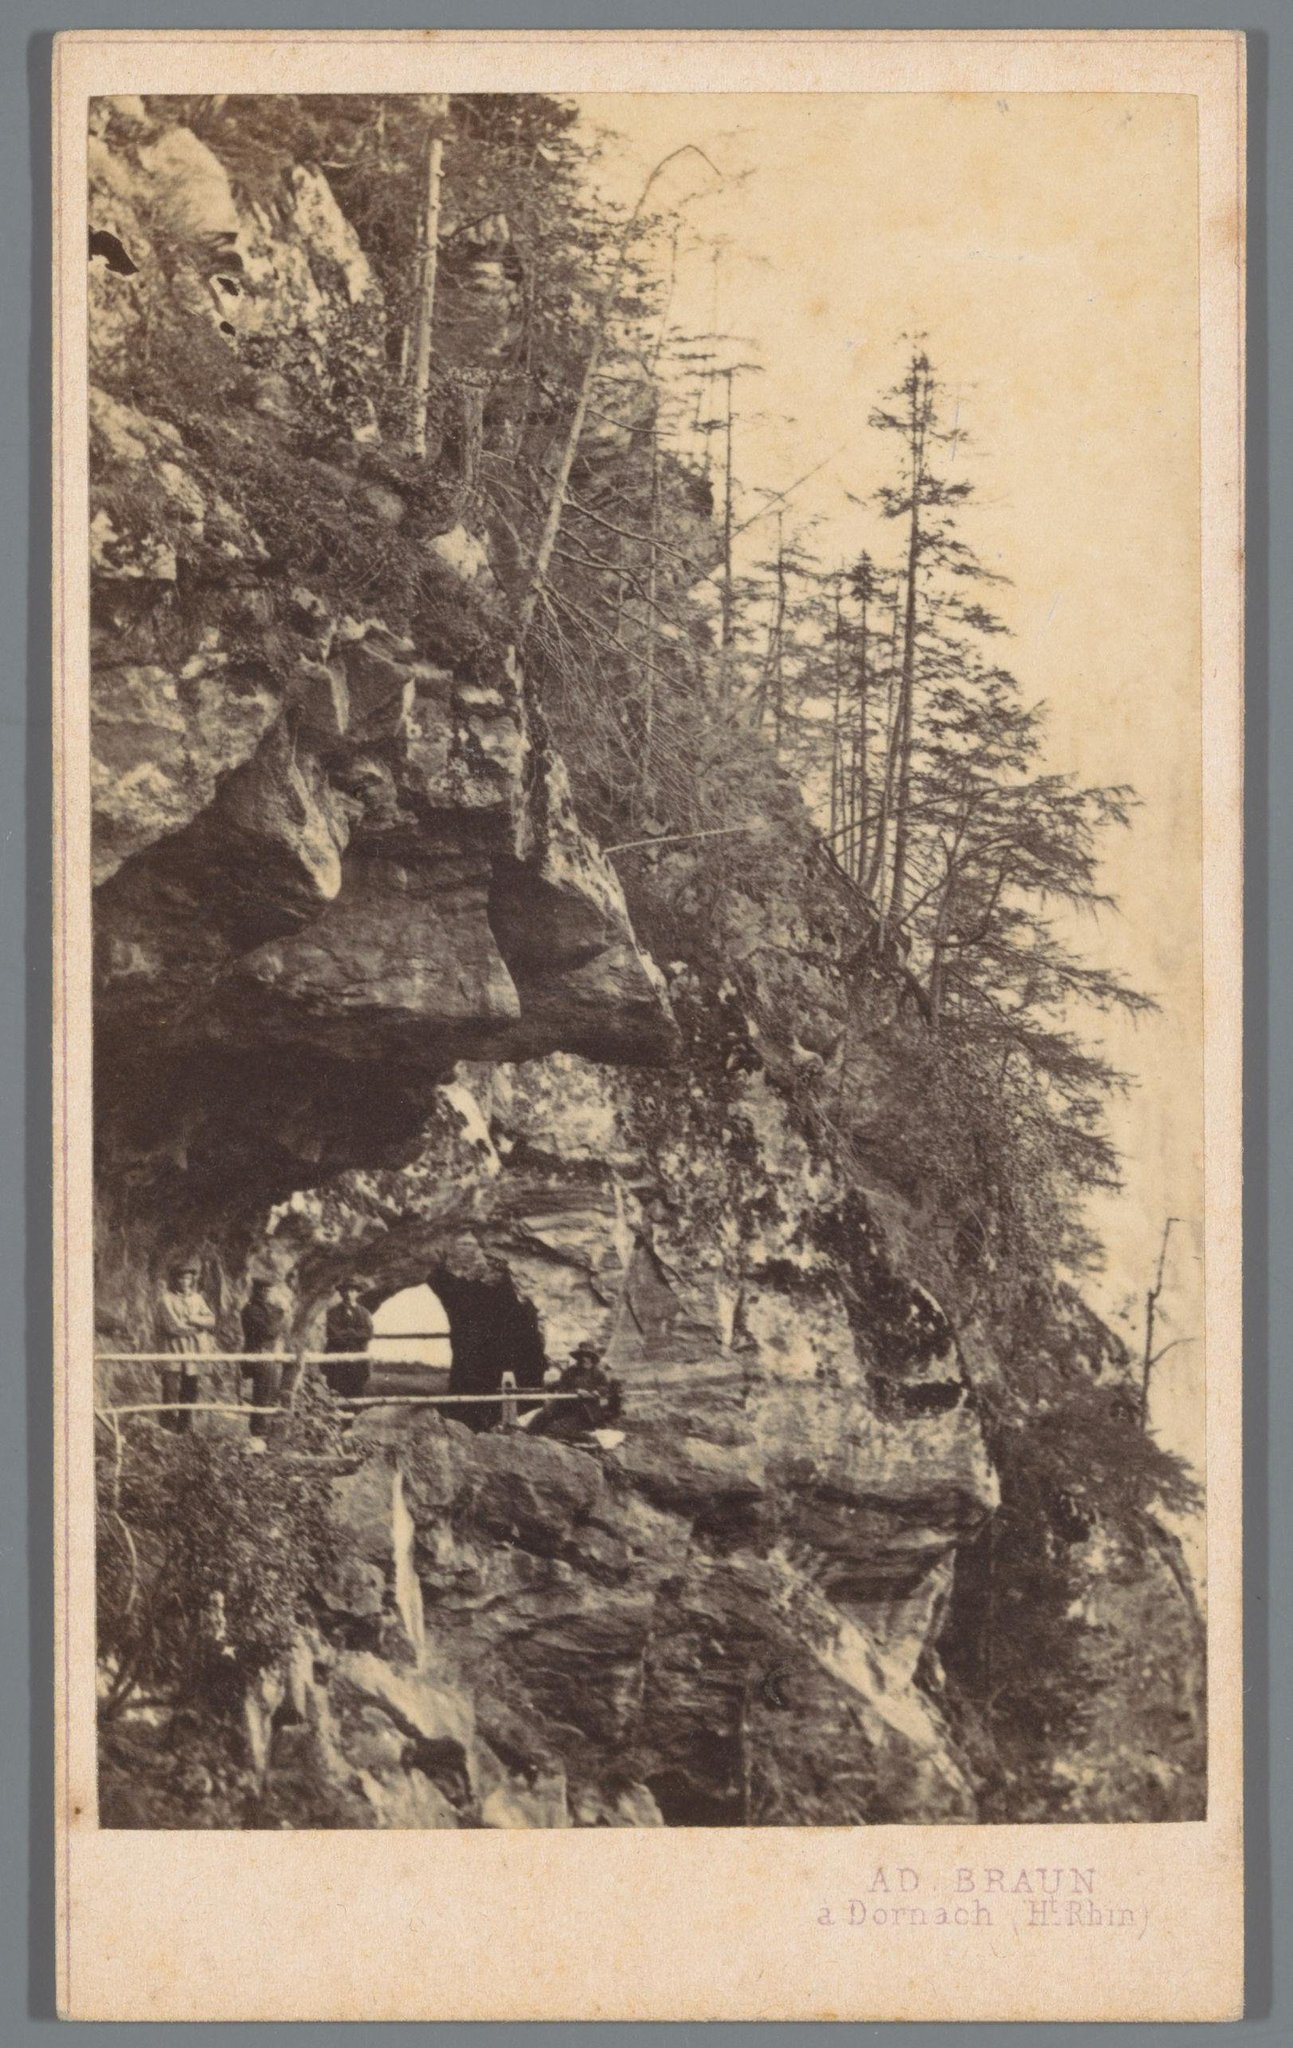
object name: carte de visite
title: Chamonix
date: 1857-1900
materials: cardboard, paper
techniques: albumen print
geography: chamonix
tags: underground road, tunnel, mountains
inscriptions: stamp: ‘AD BRAUN/ PHOTOGAPHE/ DE/ S.M. L'EMPEREUR/ à Dornach (Ht Rhin)’, number: ‘1821’